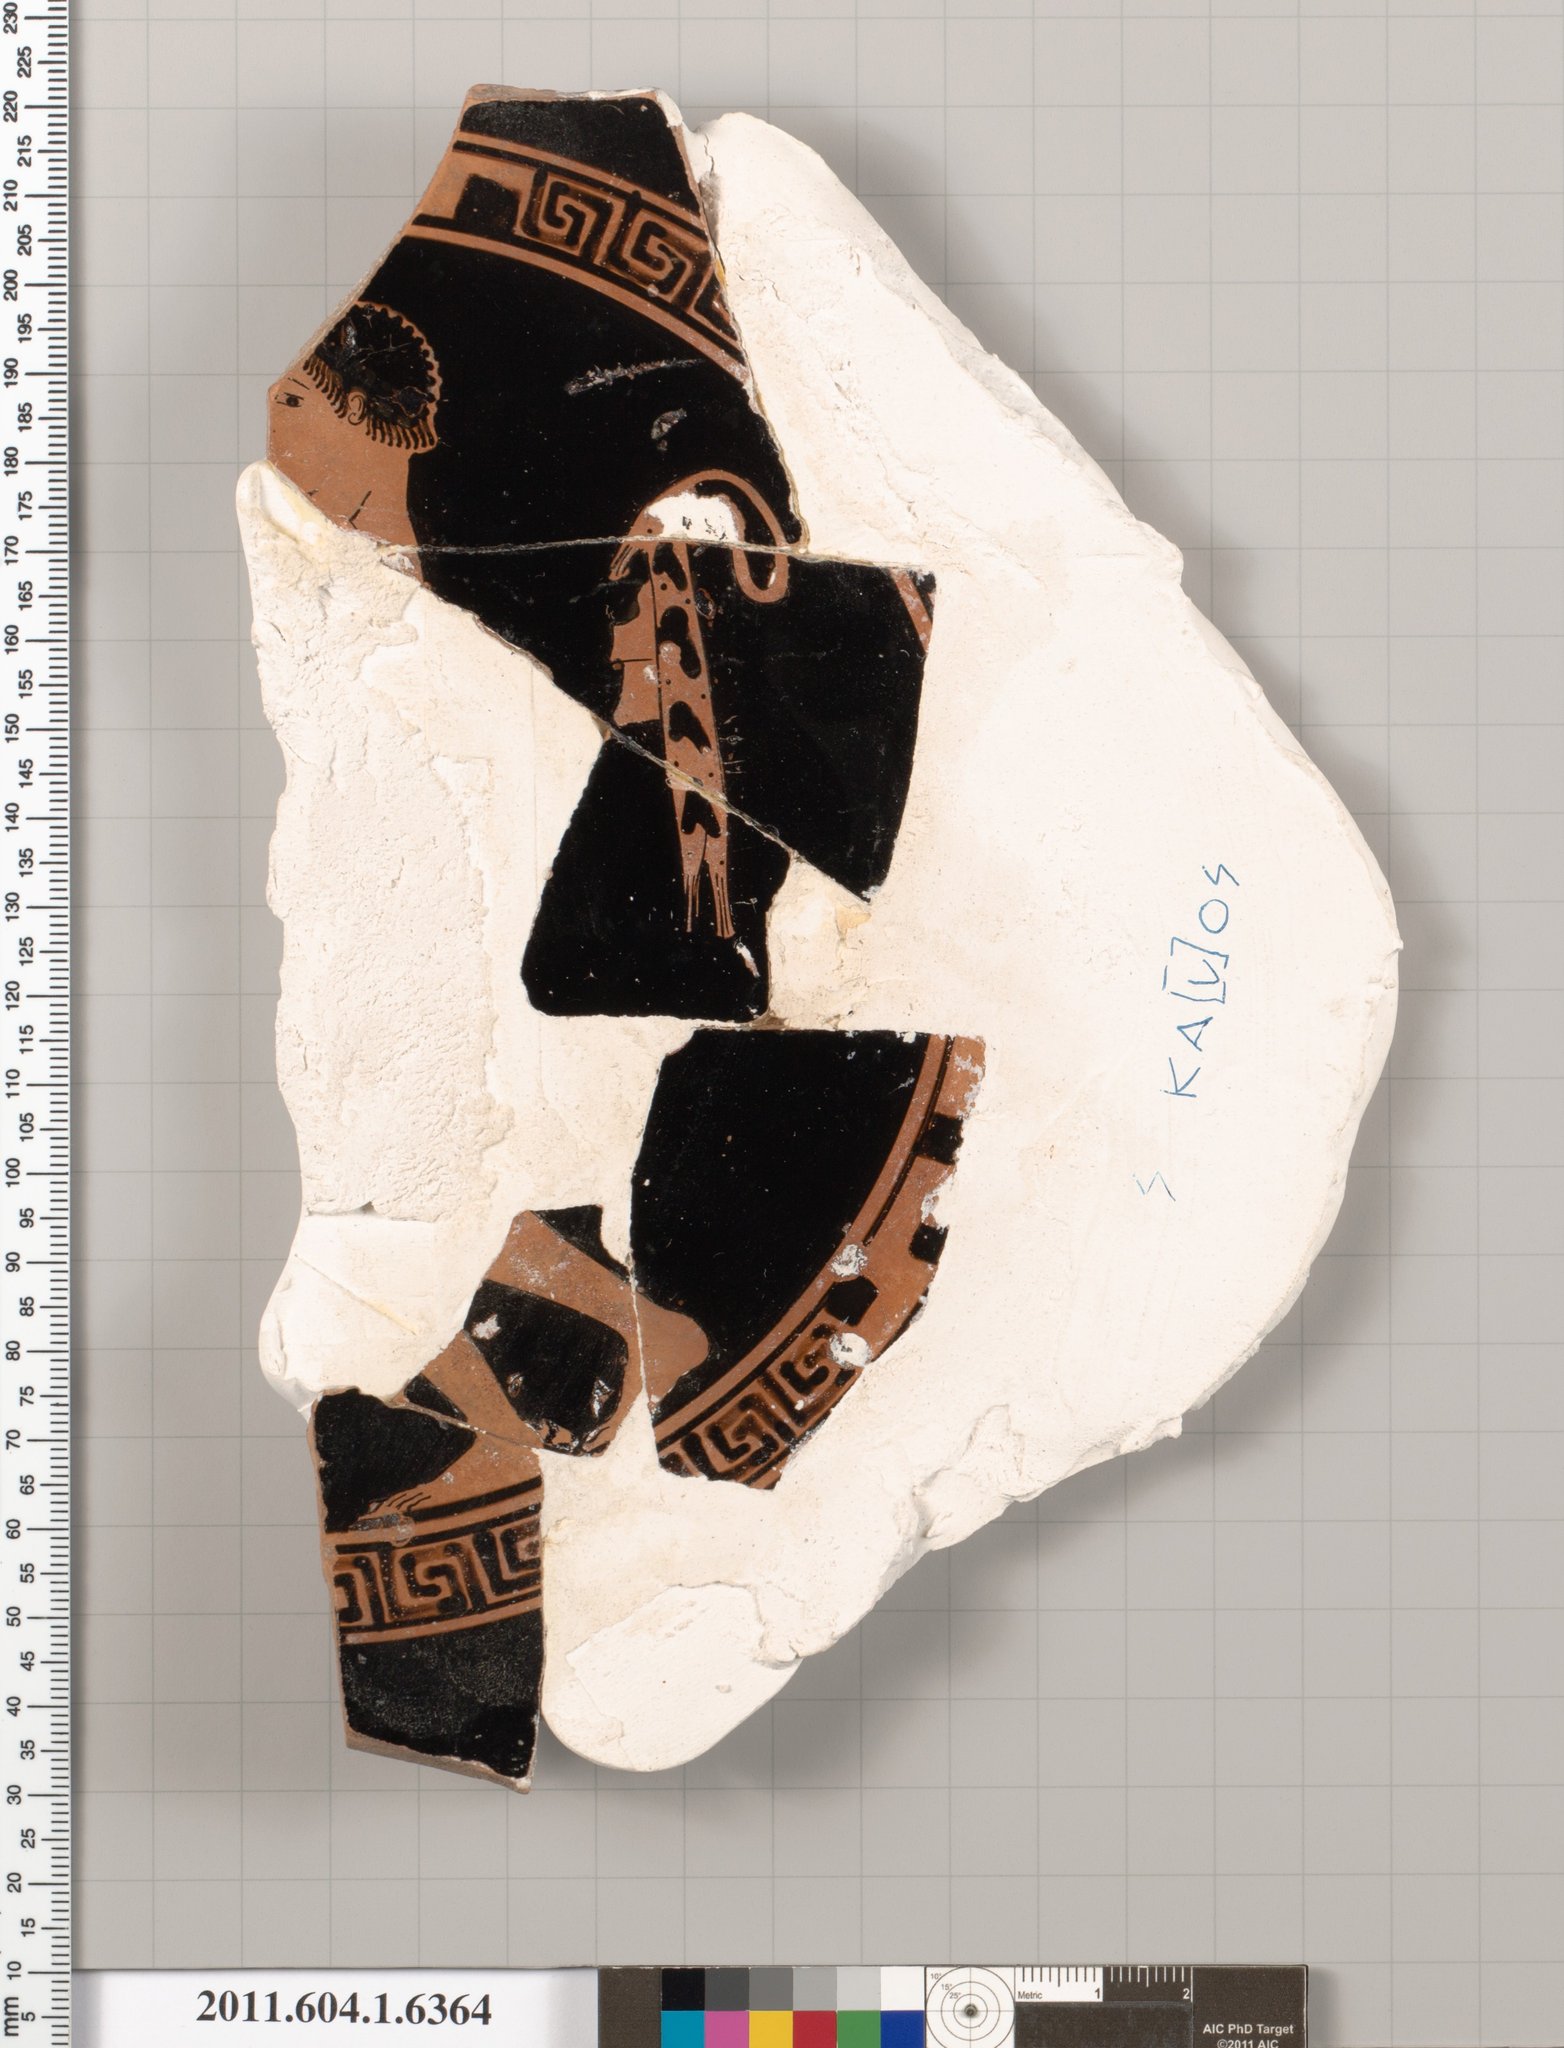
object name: kylix fragment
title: Terracotta fragment of a kylix (drinking cup)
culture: greek, attic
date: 490-480 BCE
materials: terracotta